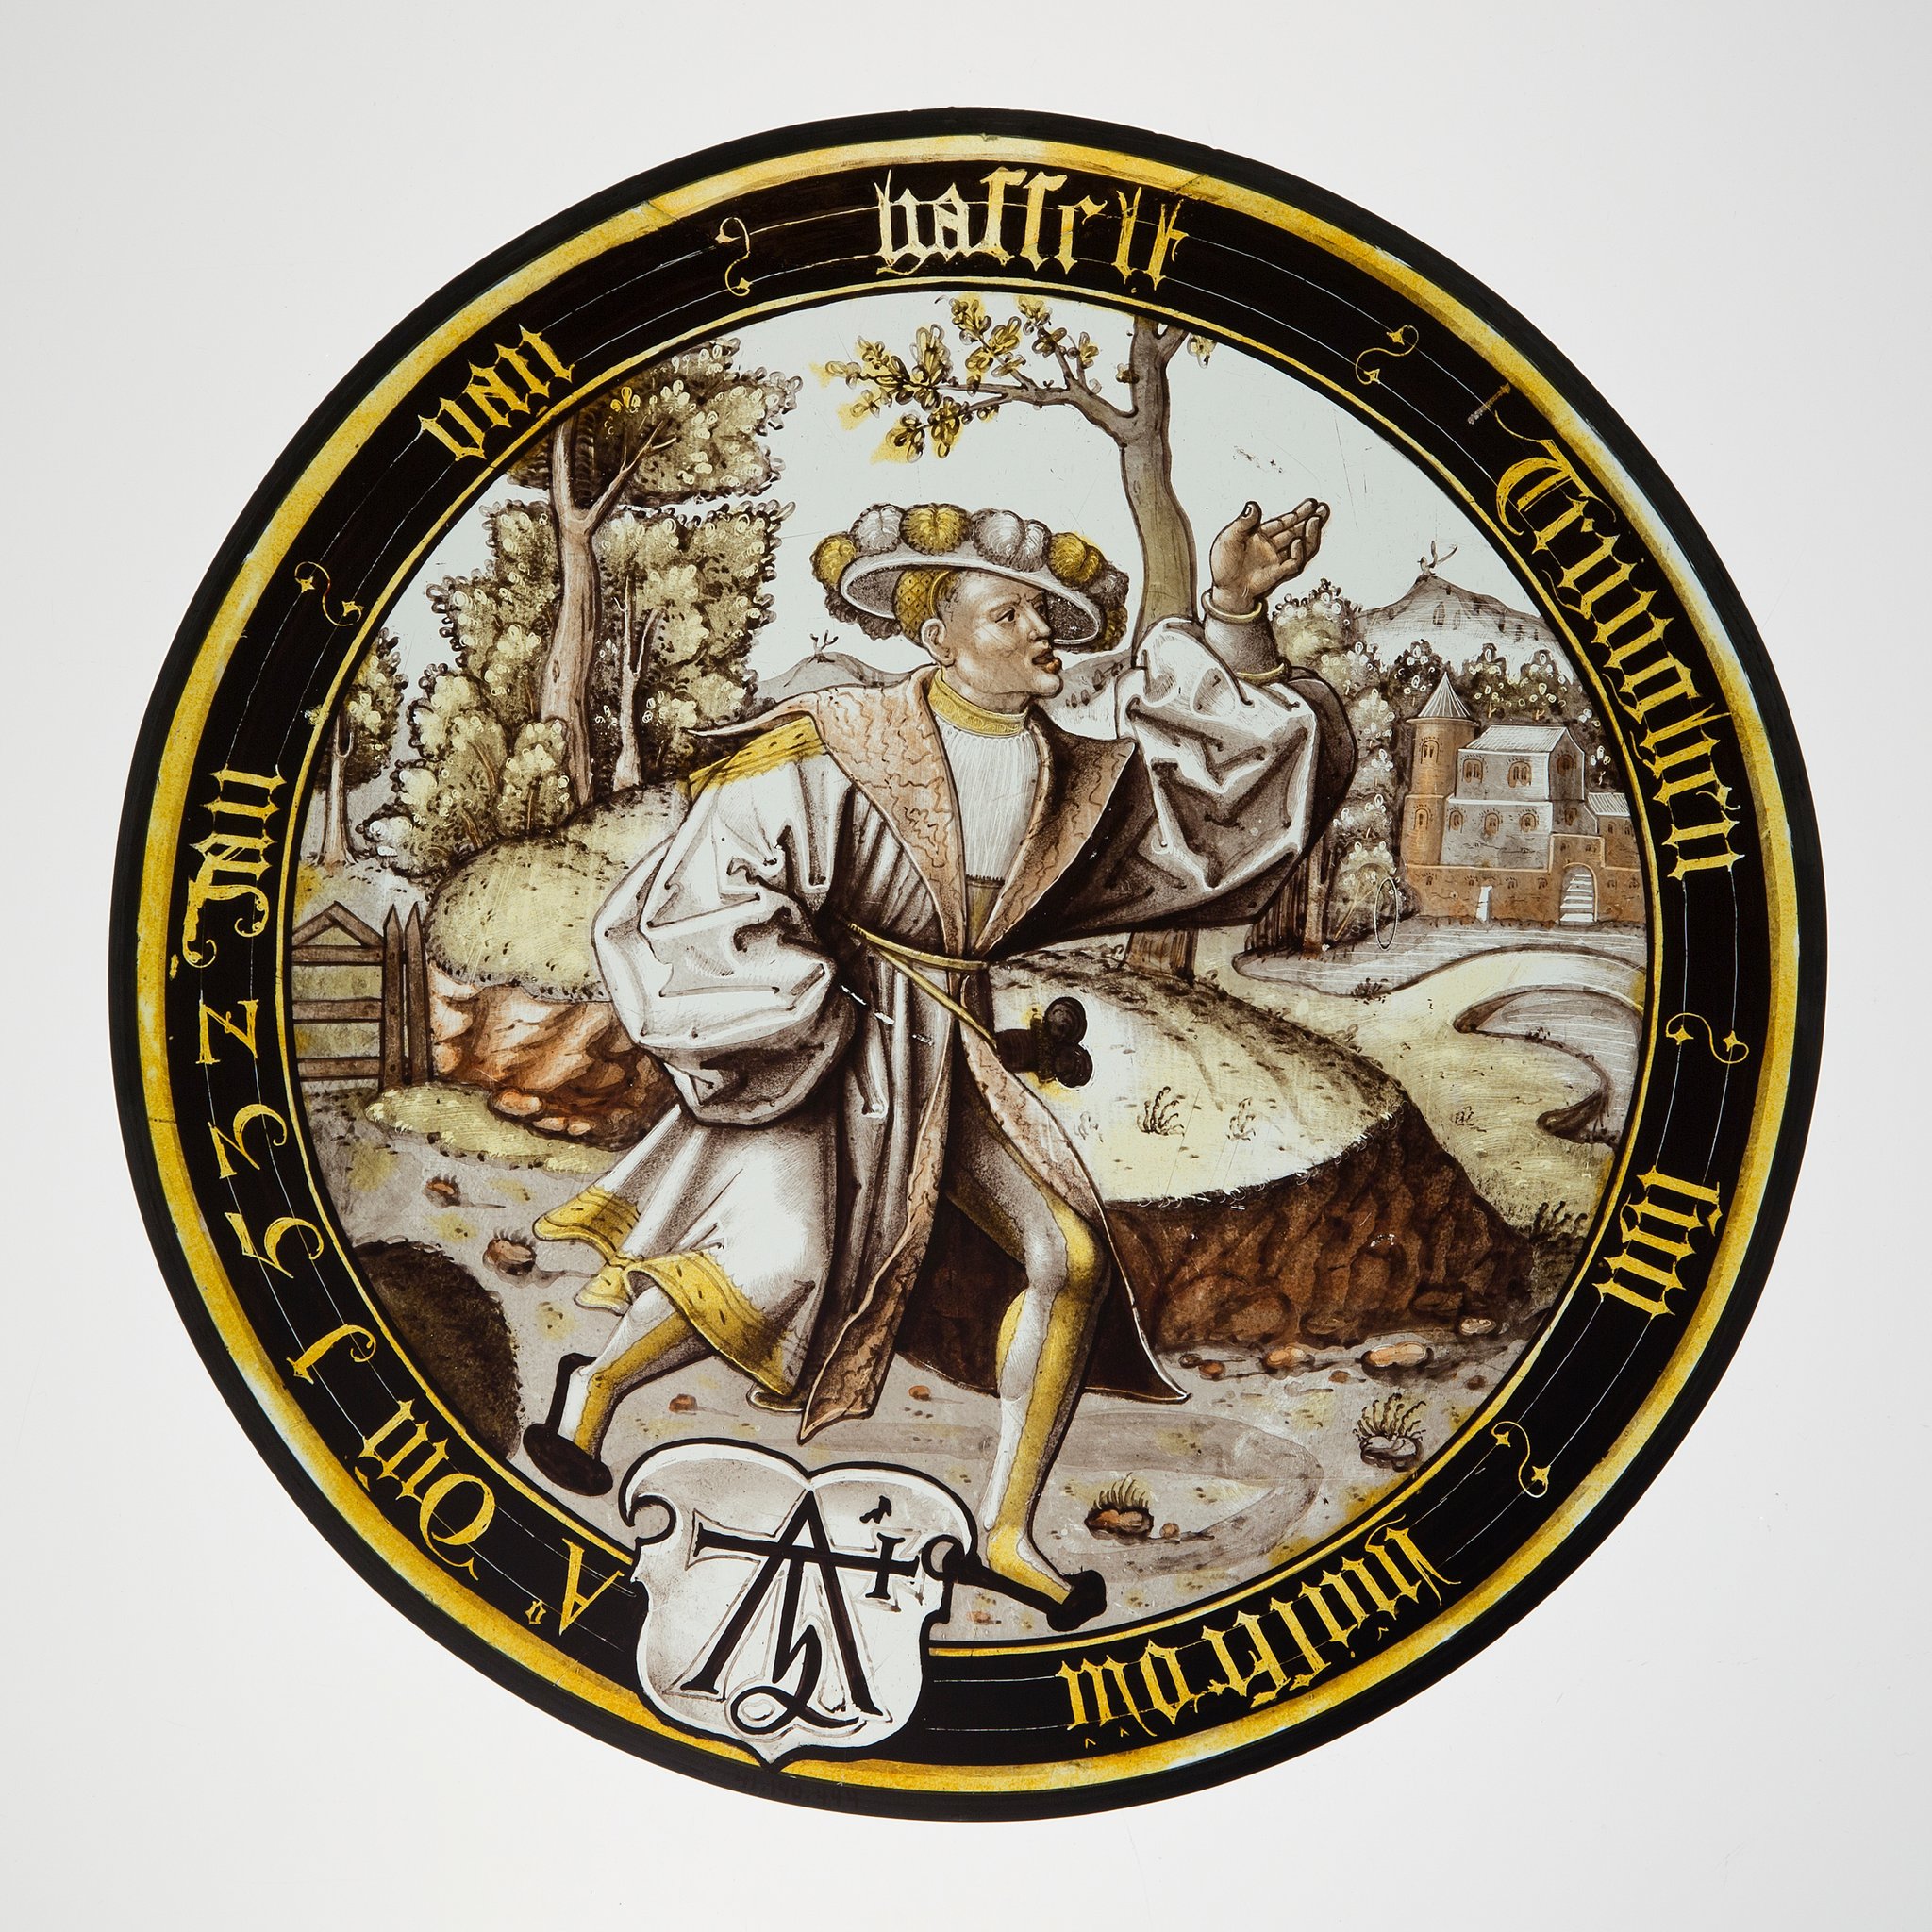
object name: roundel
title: The Prodigal Sets Out (one of eight scenes from the story of the Prodigal Son)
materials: glass, paint, pigment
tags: men,trees,insignia